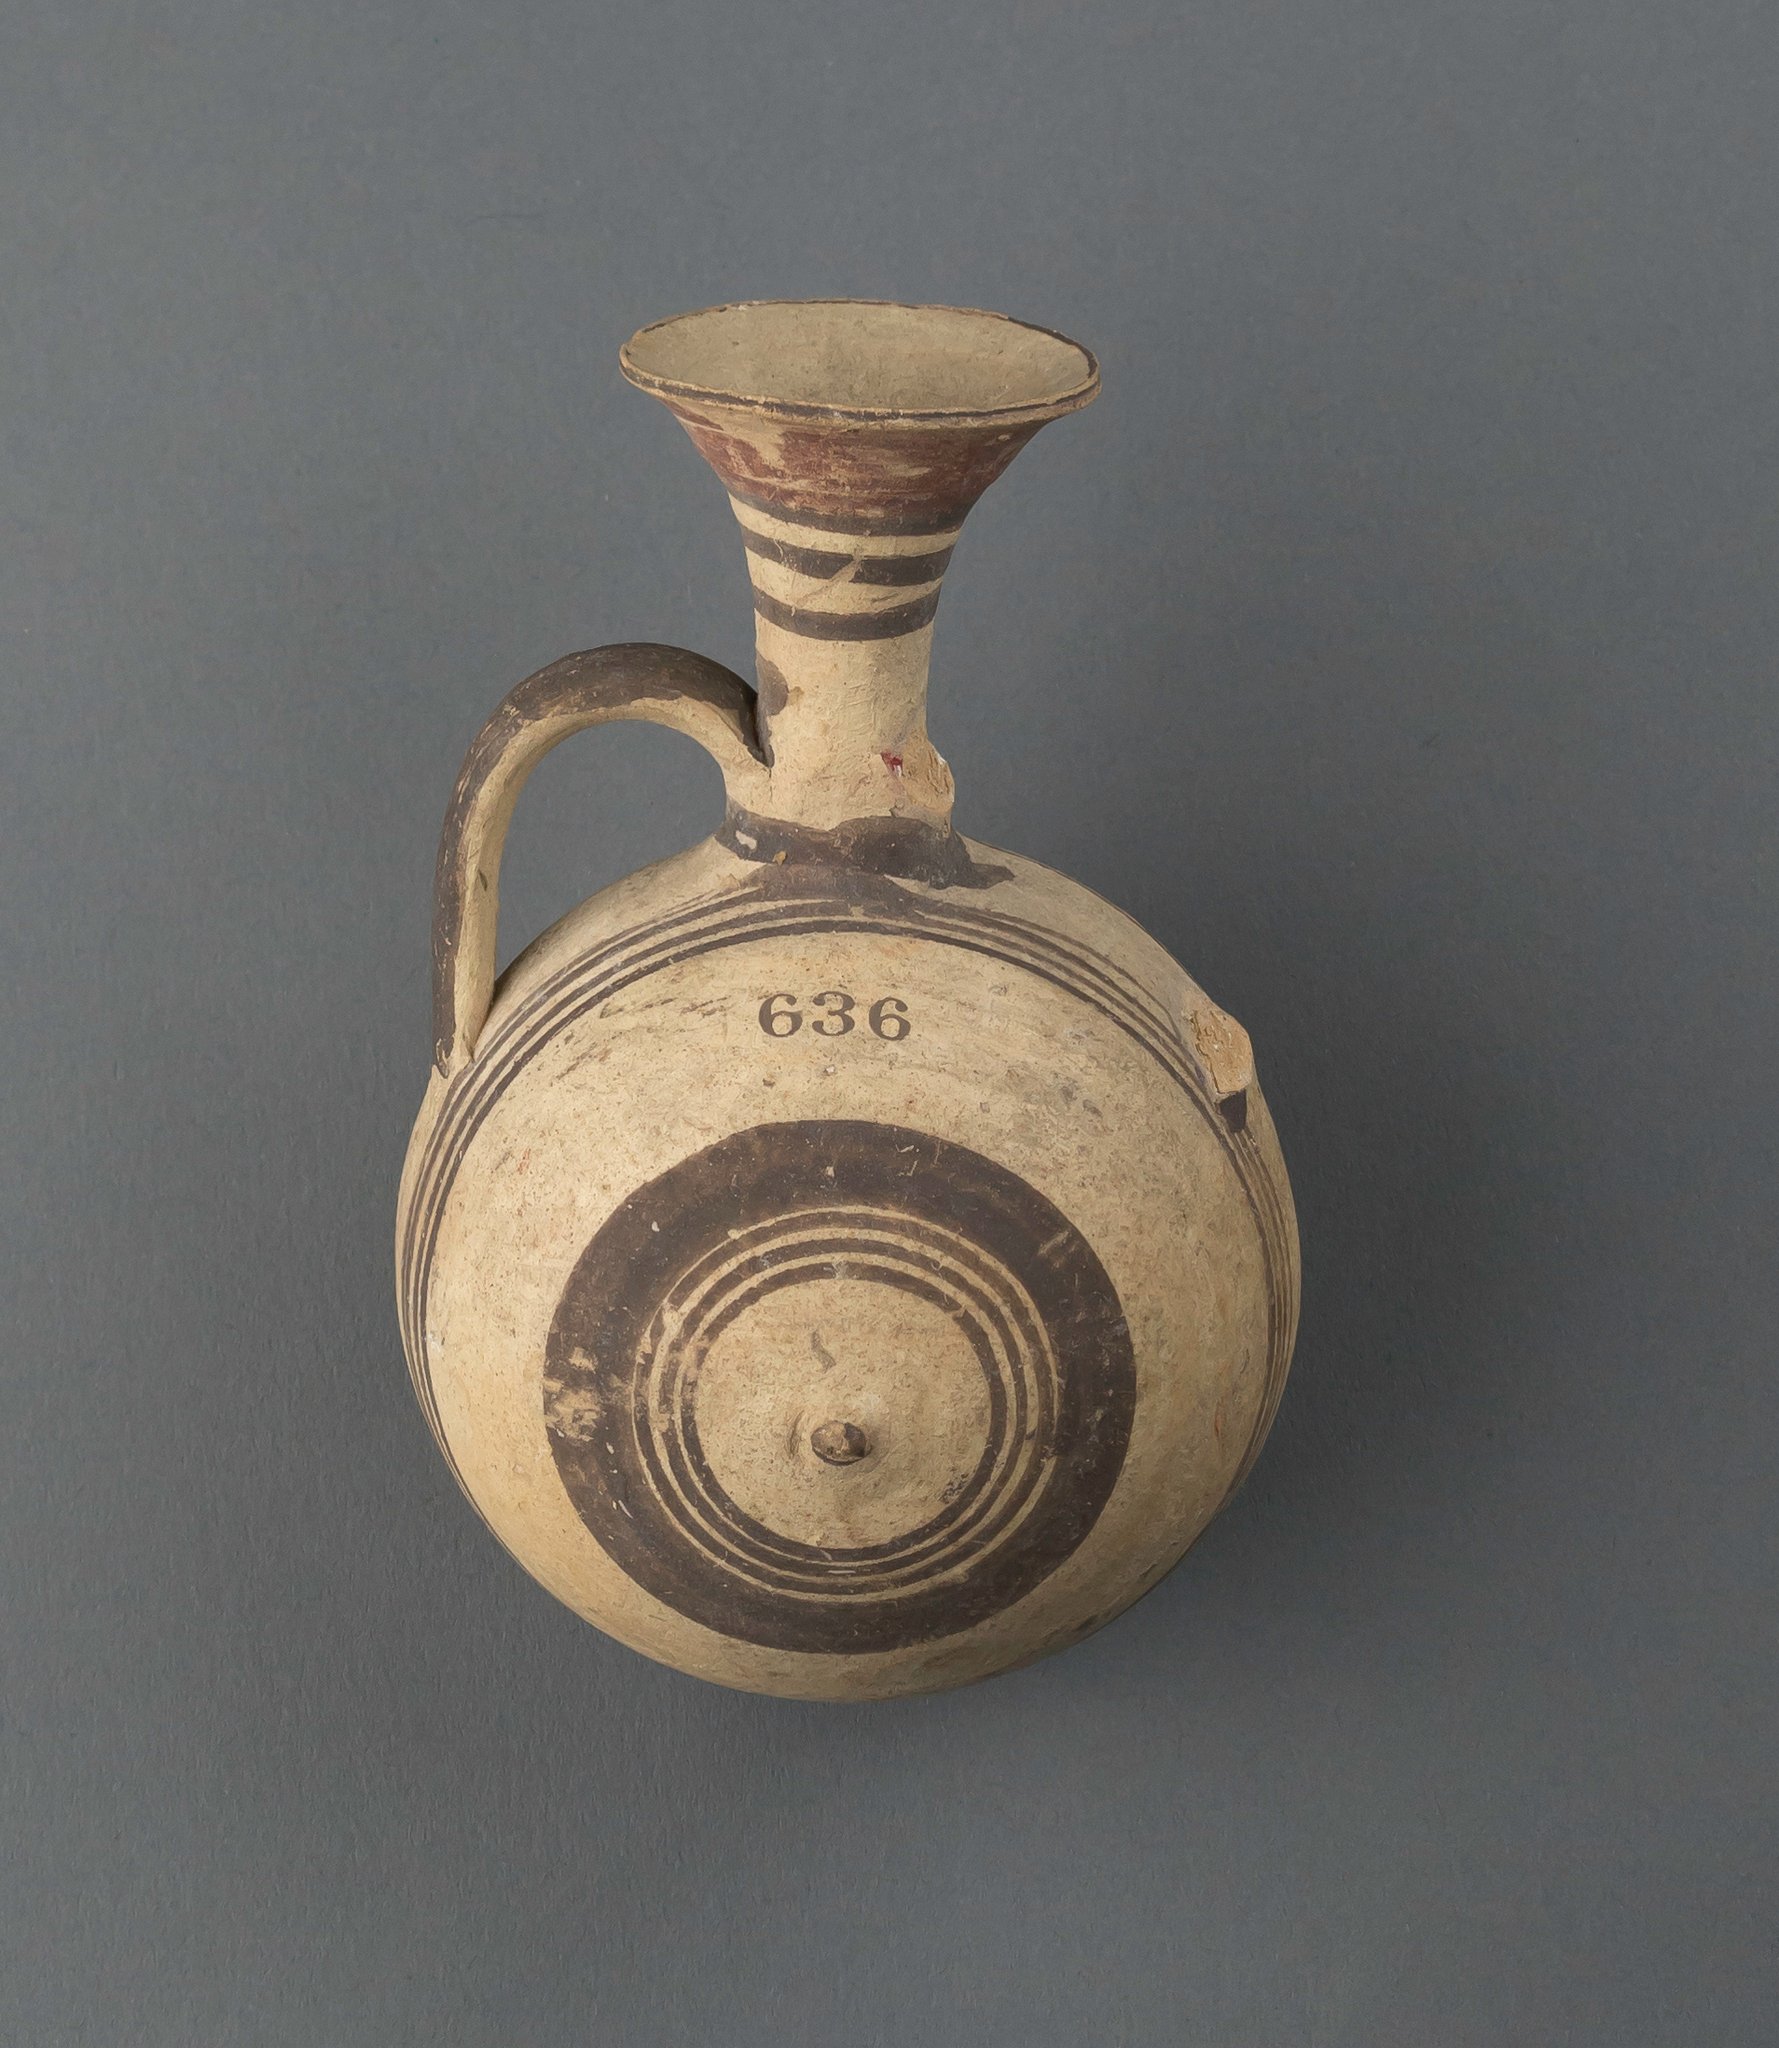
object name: jug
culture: cypriot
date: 507-323 BCE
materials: terracotta